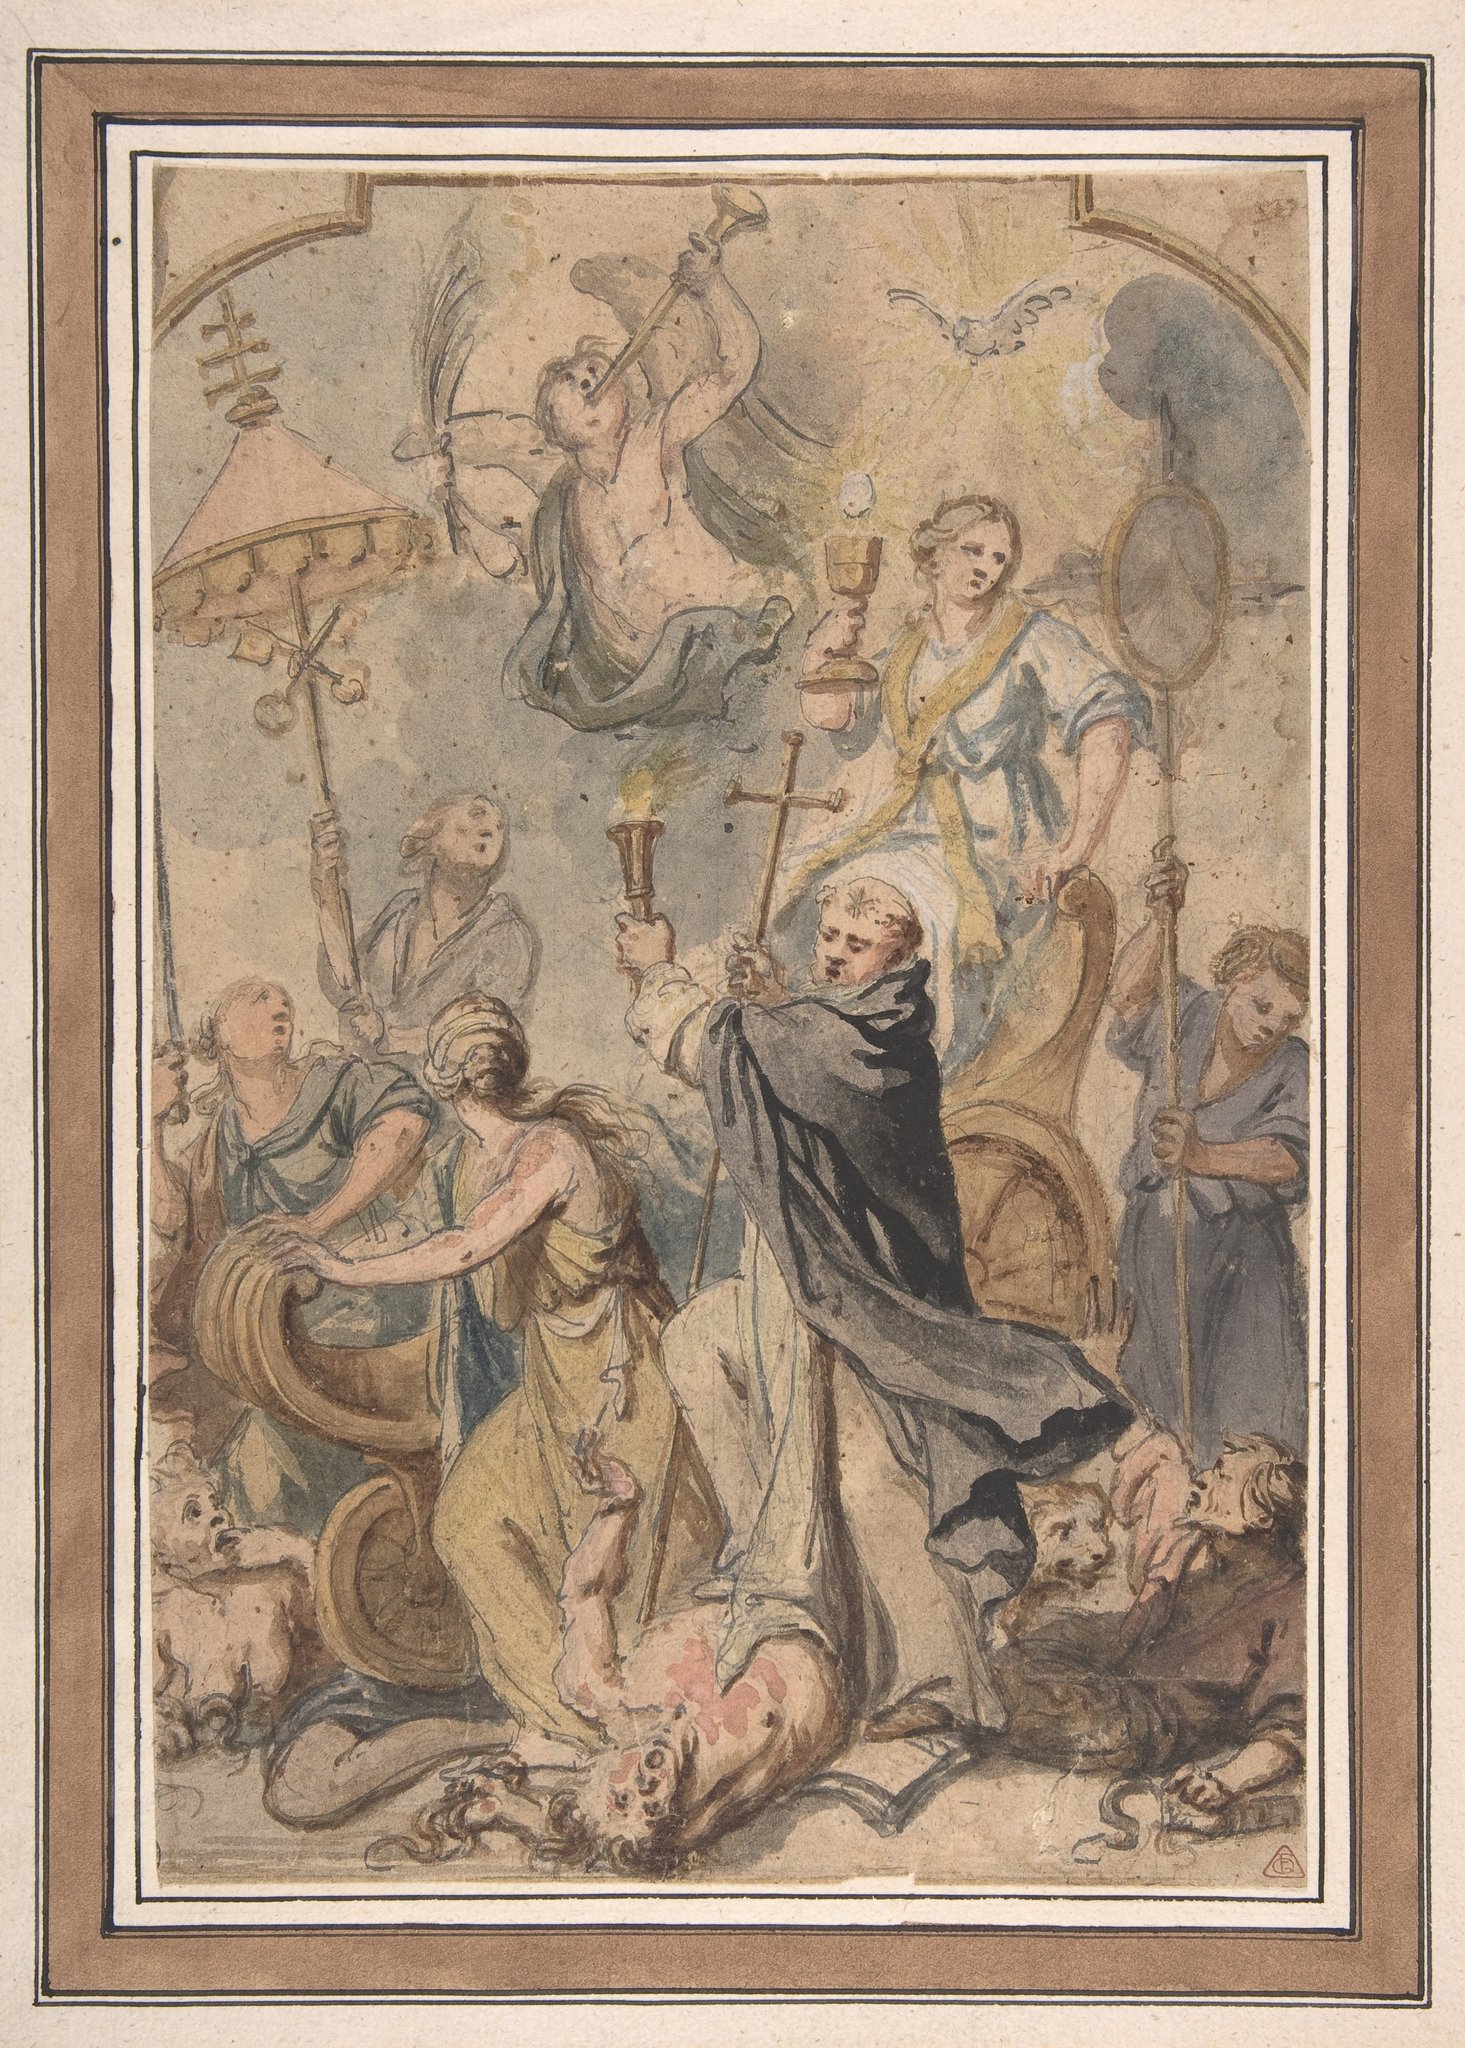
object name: drawing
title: An Allegory of the Triumph over Heresy, with St. Domenic to the Fore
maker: abraham van diepenbeeck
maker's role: artist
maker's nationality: flemish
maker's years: 1596-1675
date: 1650-1660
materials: chalk, ink, watercolor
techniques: heightening, pen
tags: suffering,men,women,cross